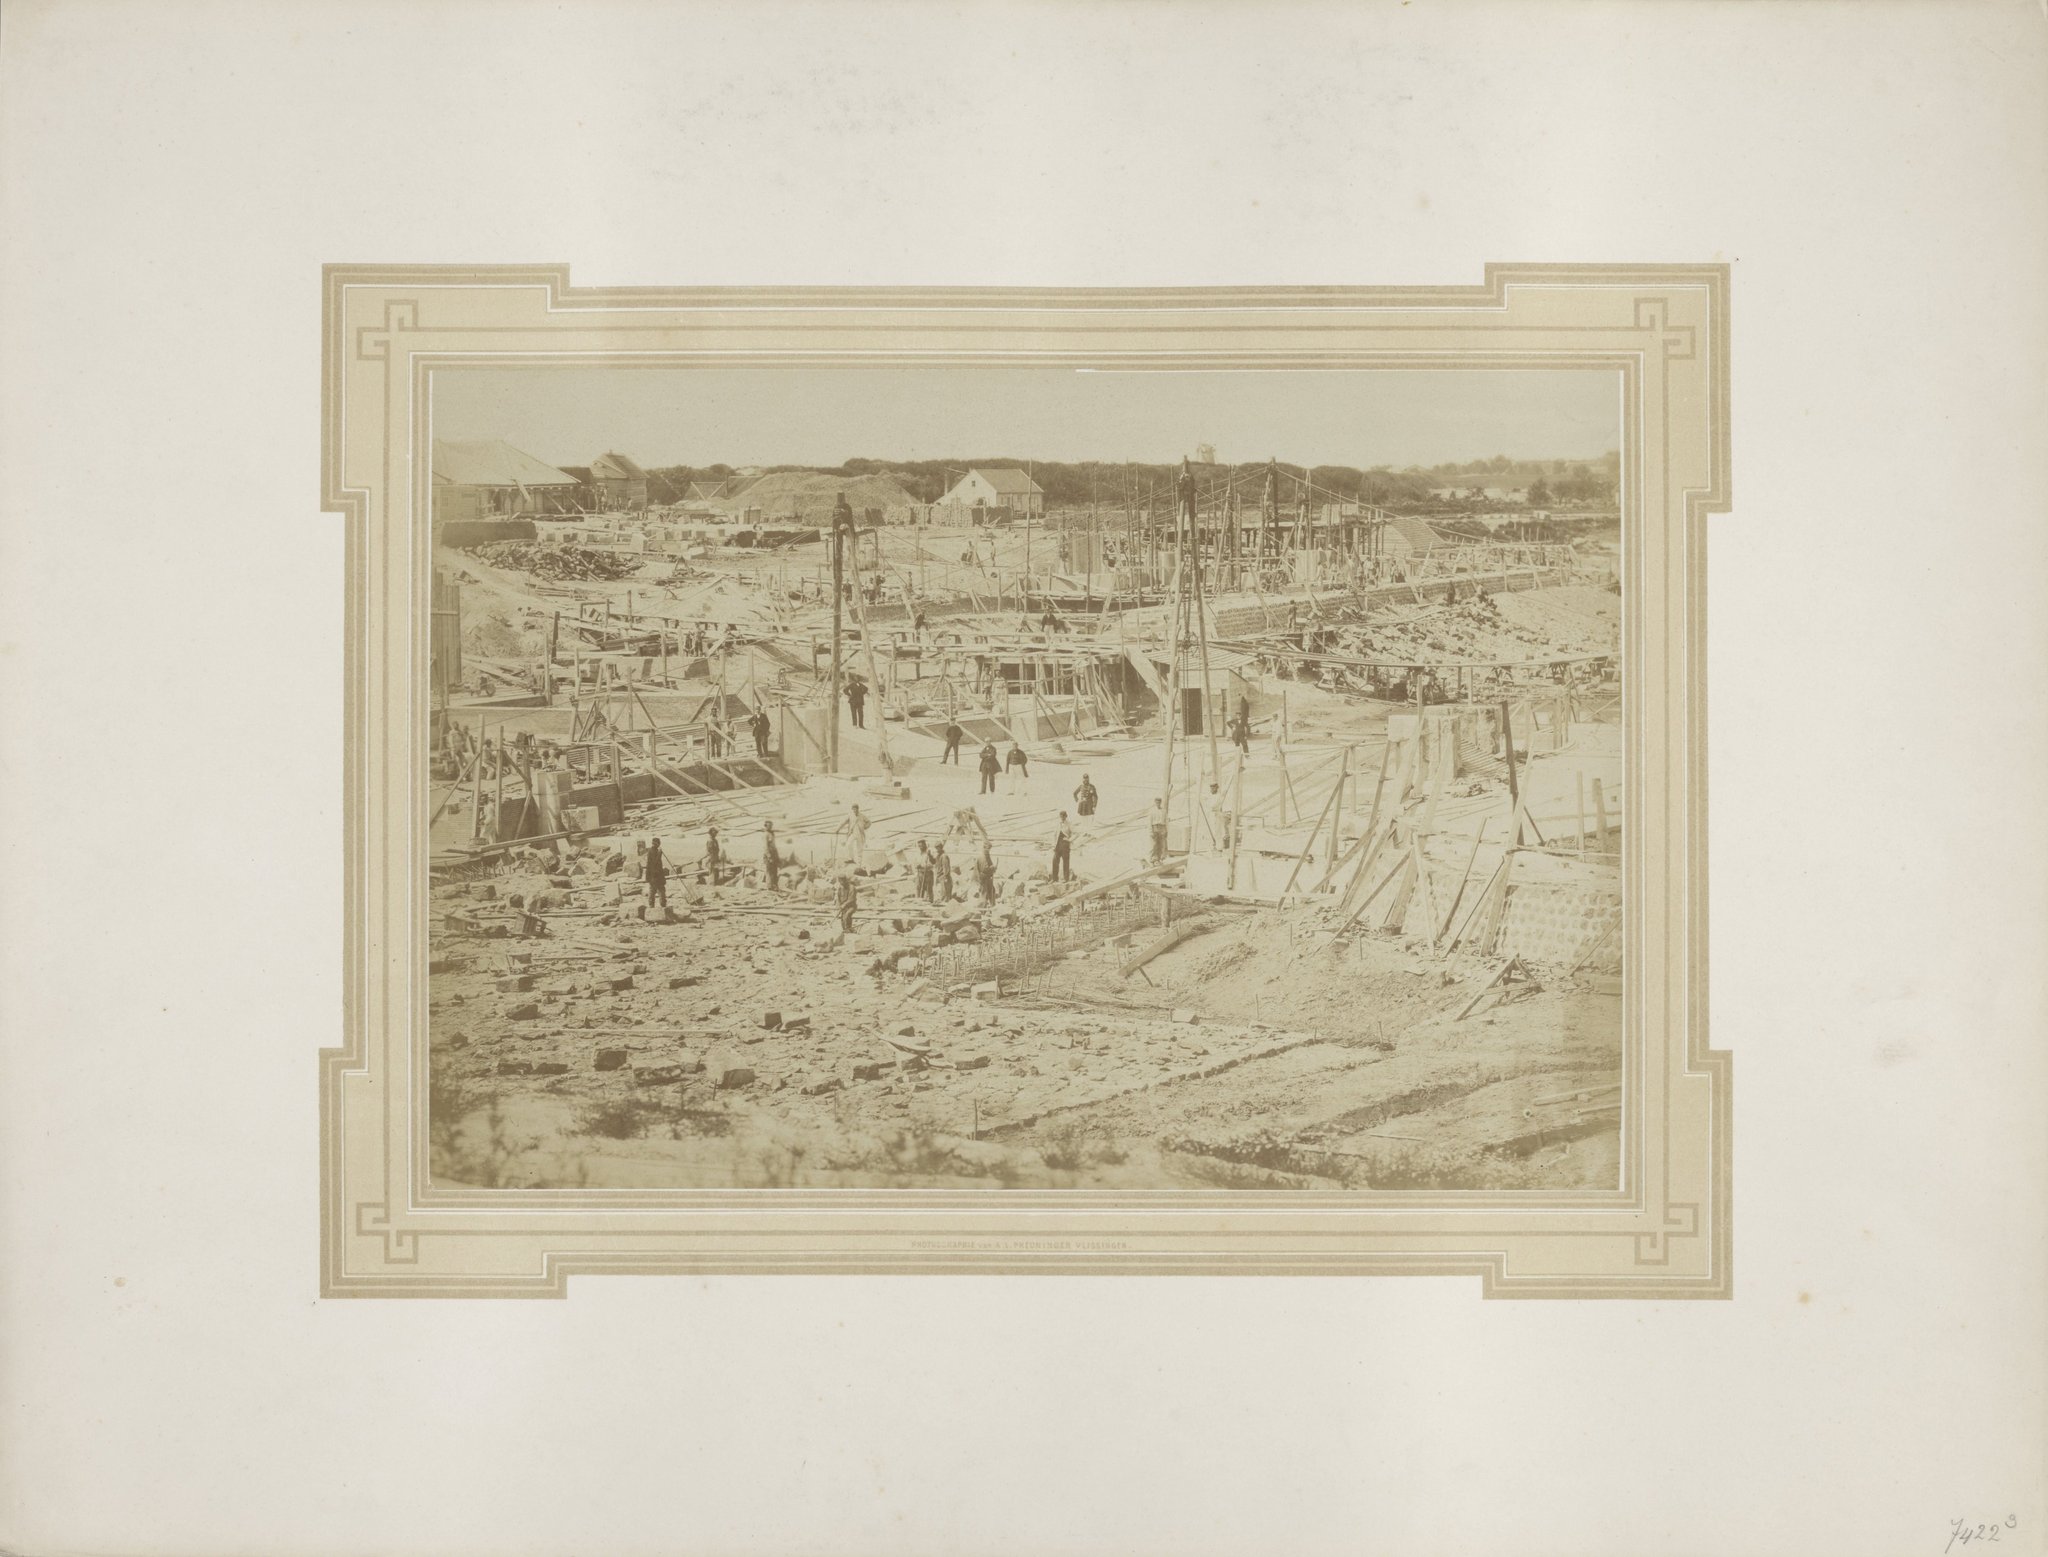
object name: photograph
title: Aanleg (betonstorting) van de dubbele schutsluis te Vlissingen, gezien vanuit het noordoosten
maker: anton lauwrens preuninger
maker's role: fotograaf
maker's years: 1846-1919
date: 1807-1869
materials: cardboard, paper, photographic support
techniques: albumen print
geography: flushing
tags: sluice, weir, canal, building-site, flushing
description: Betonstorting tijdens de aanleg van de dubbele schutsluis te Vlissingen, gezien vanuit het noordoosten, juli 1869. Onderdeel van een serie van veertien foto's van deze bouwprojecten in Zeeland.